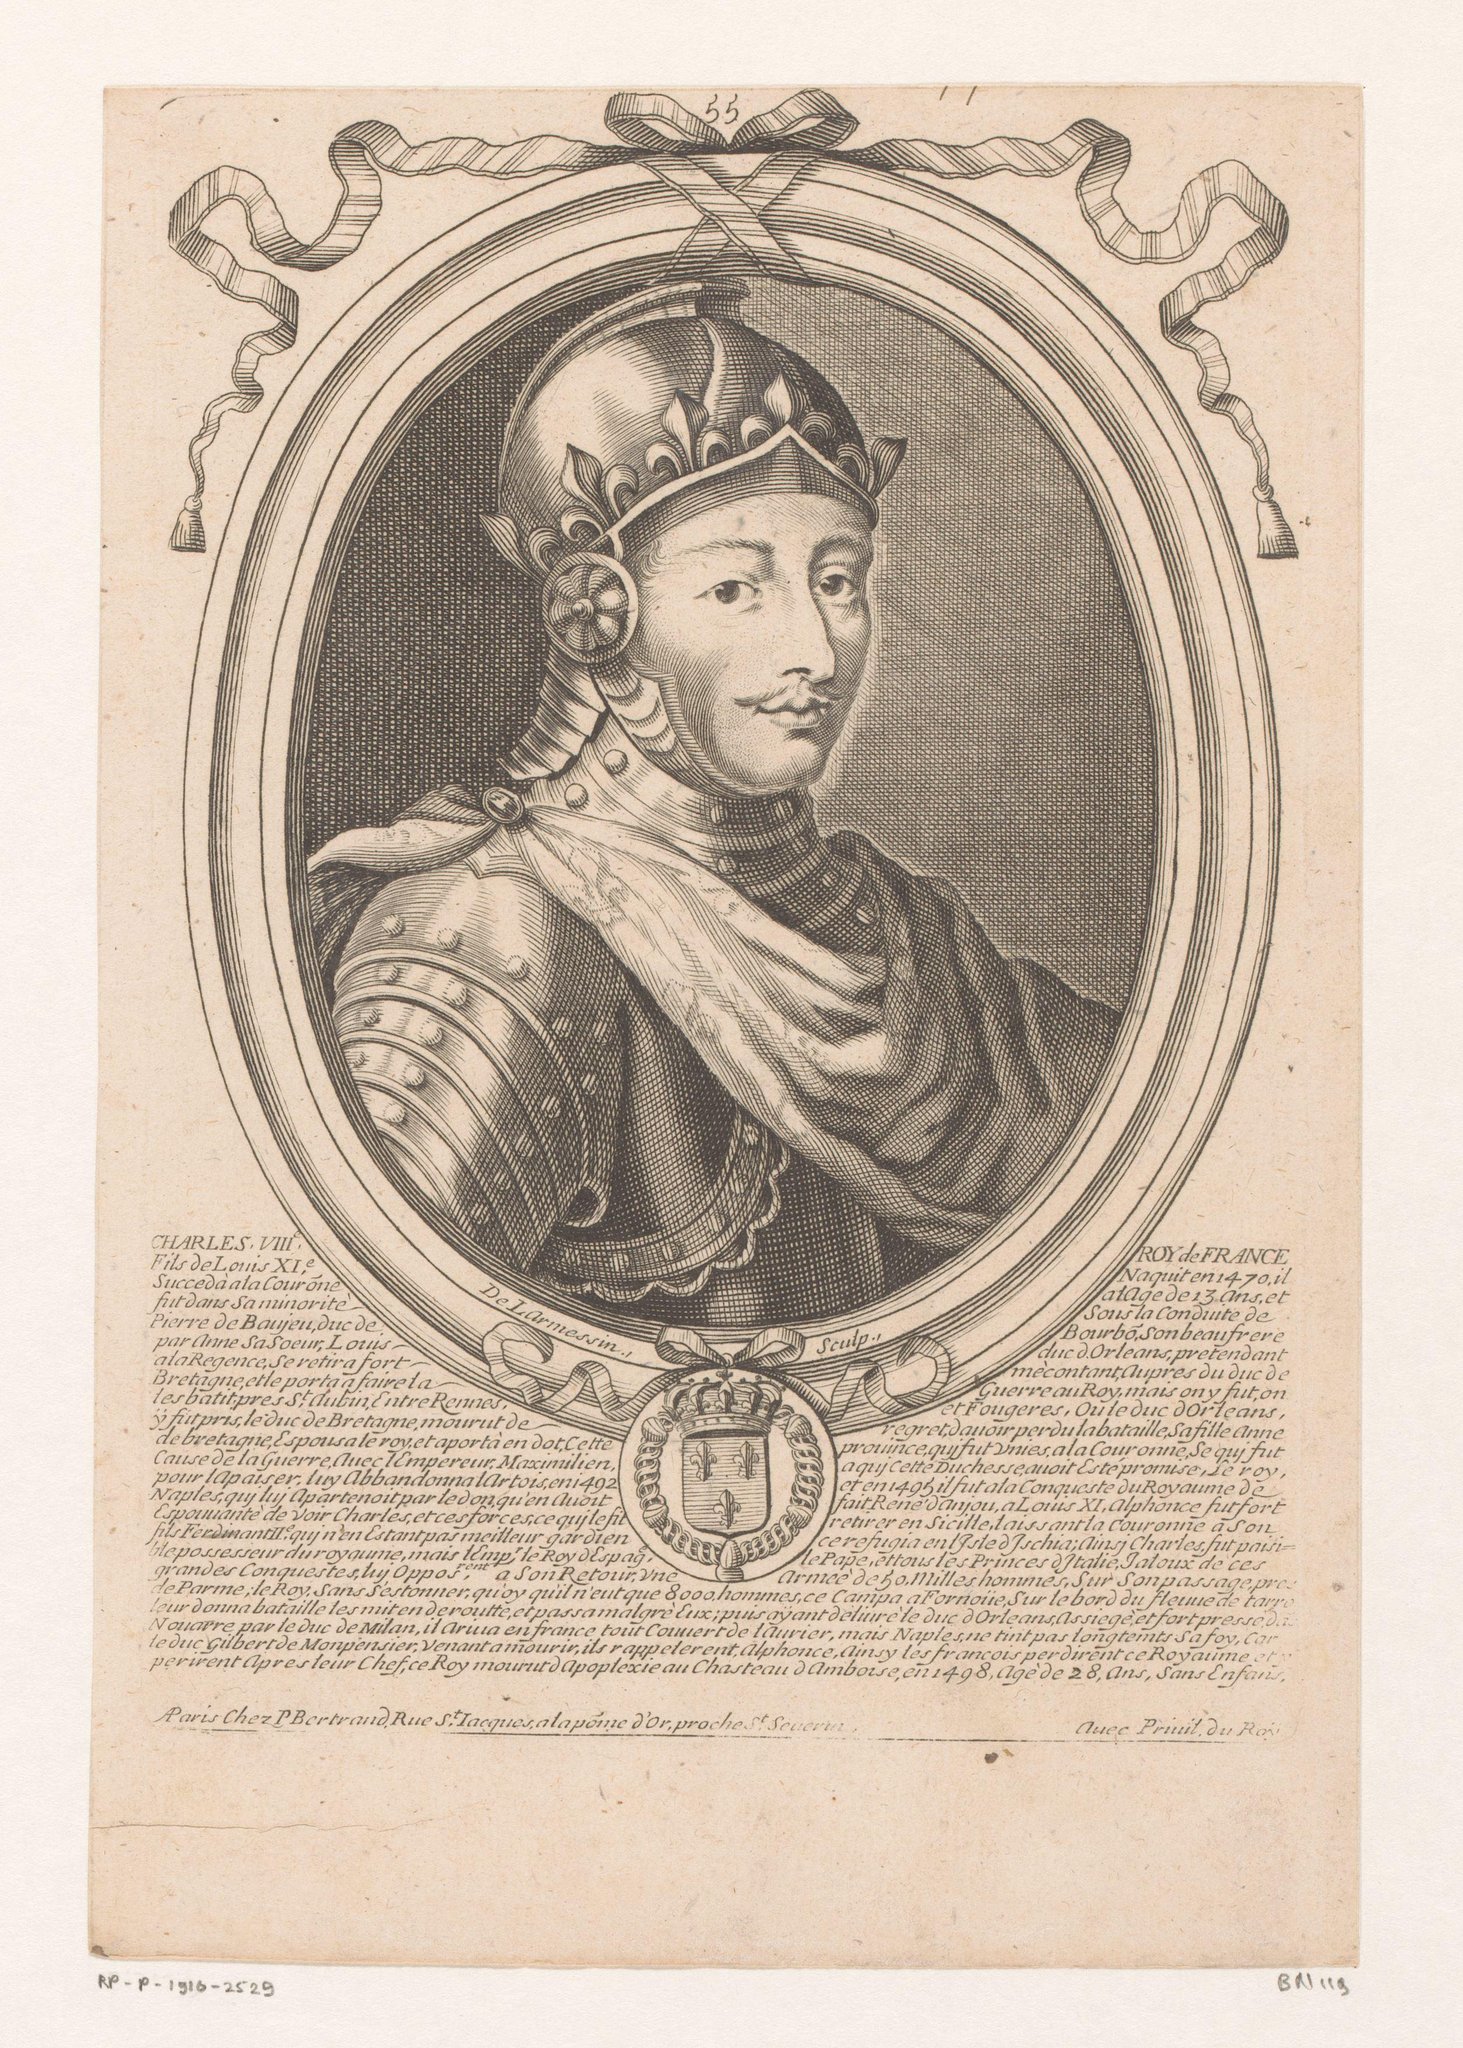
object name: print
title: Portret van Karel VII, koning van Frankrijk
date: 1642-1678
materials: paper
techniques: engraving, etching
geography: france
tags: paris, historical persons, king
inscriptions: collector's mark: Lugt 2228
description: Maakt deel uit van een grootschalige serie met portretten van prominente figuren. Binnen de serie bevindt zich een sectie getiteld 'Les Augustes Représentations De tous les Roys De France depuis Pharamond Iusqu'à Louys XIIII'. De serie werd respectievelijk uitgegeven door Pierre Bertrand, door zijn weduwe en door De Larmessin zelf.